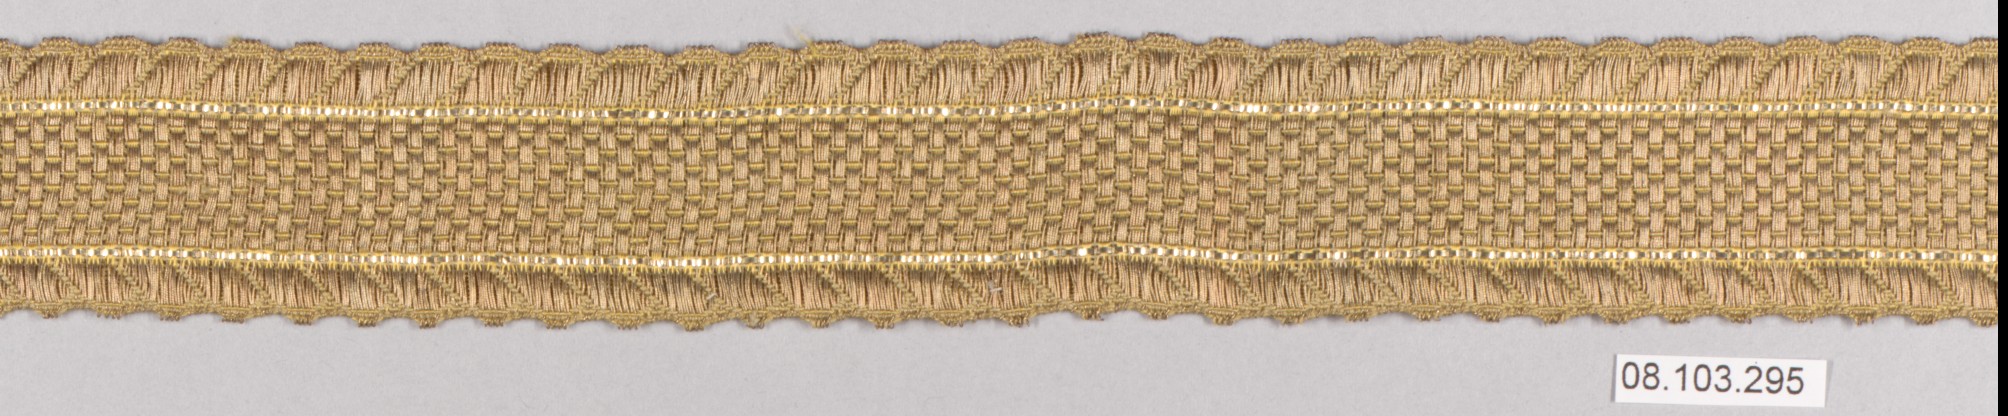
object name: galloon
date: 1601-1800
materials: metal thread